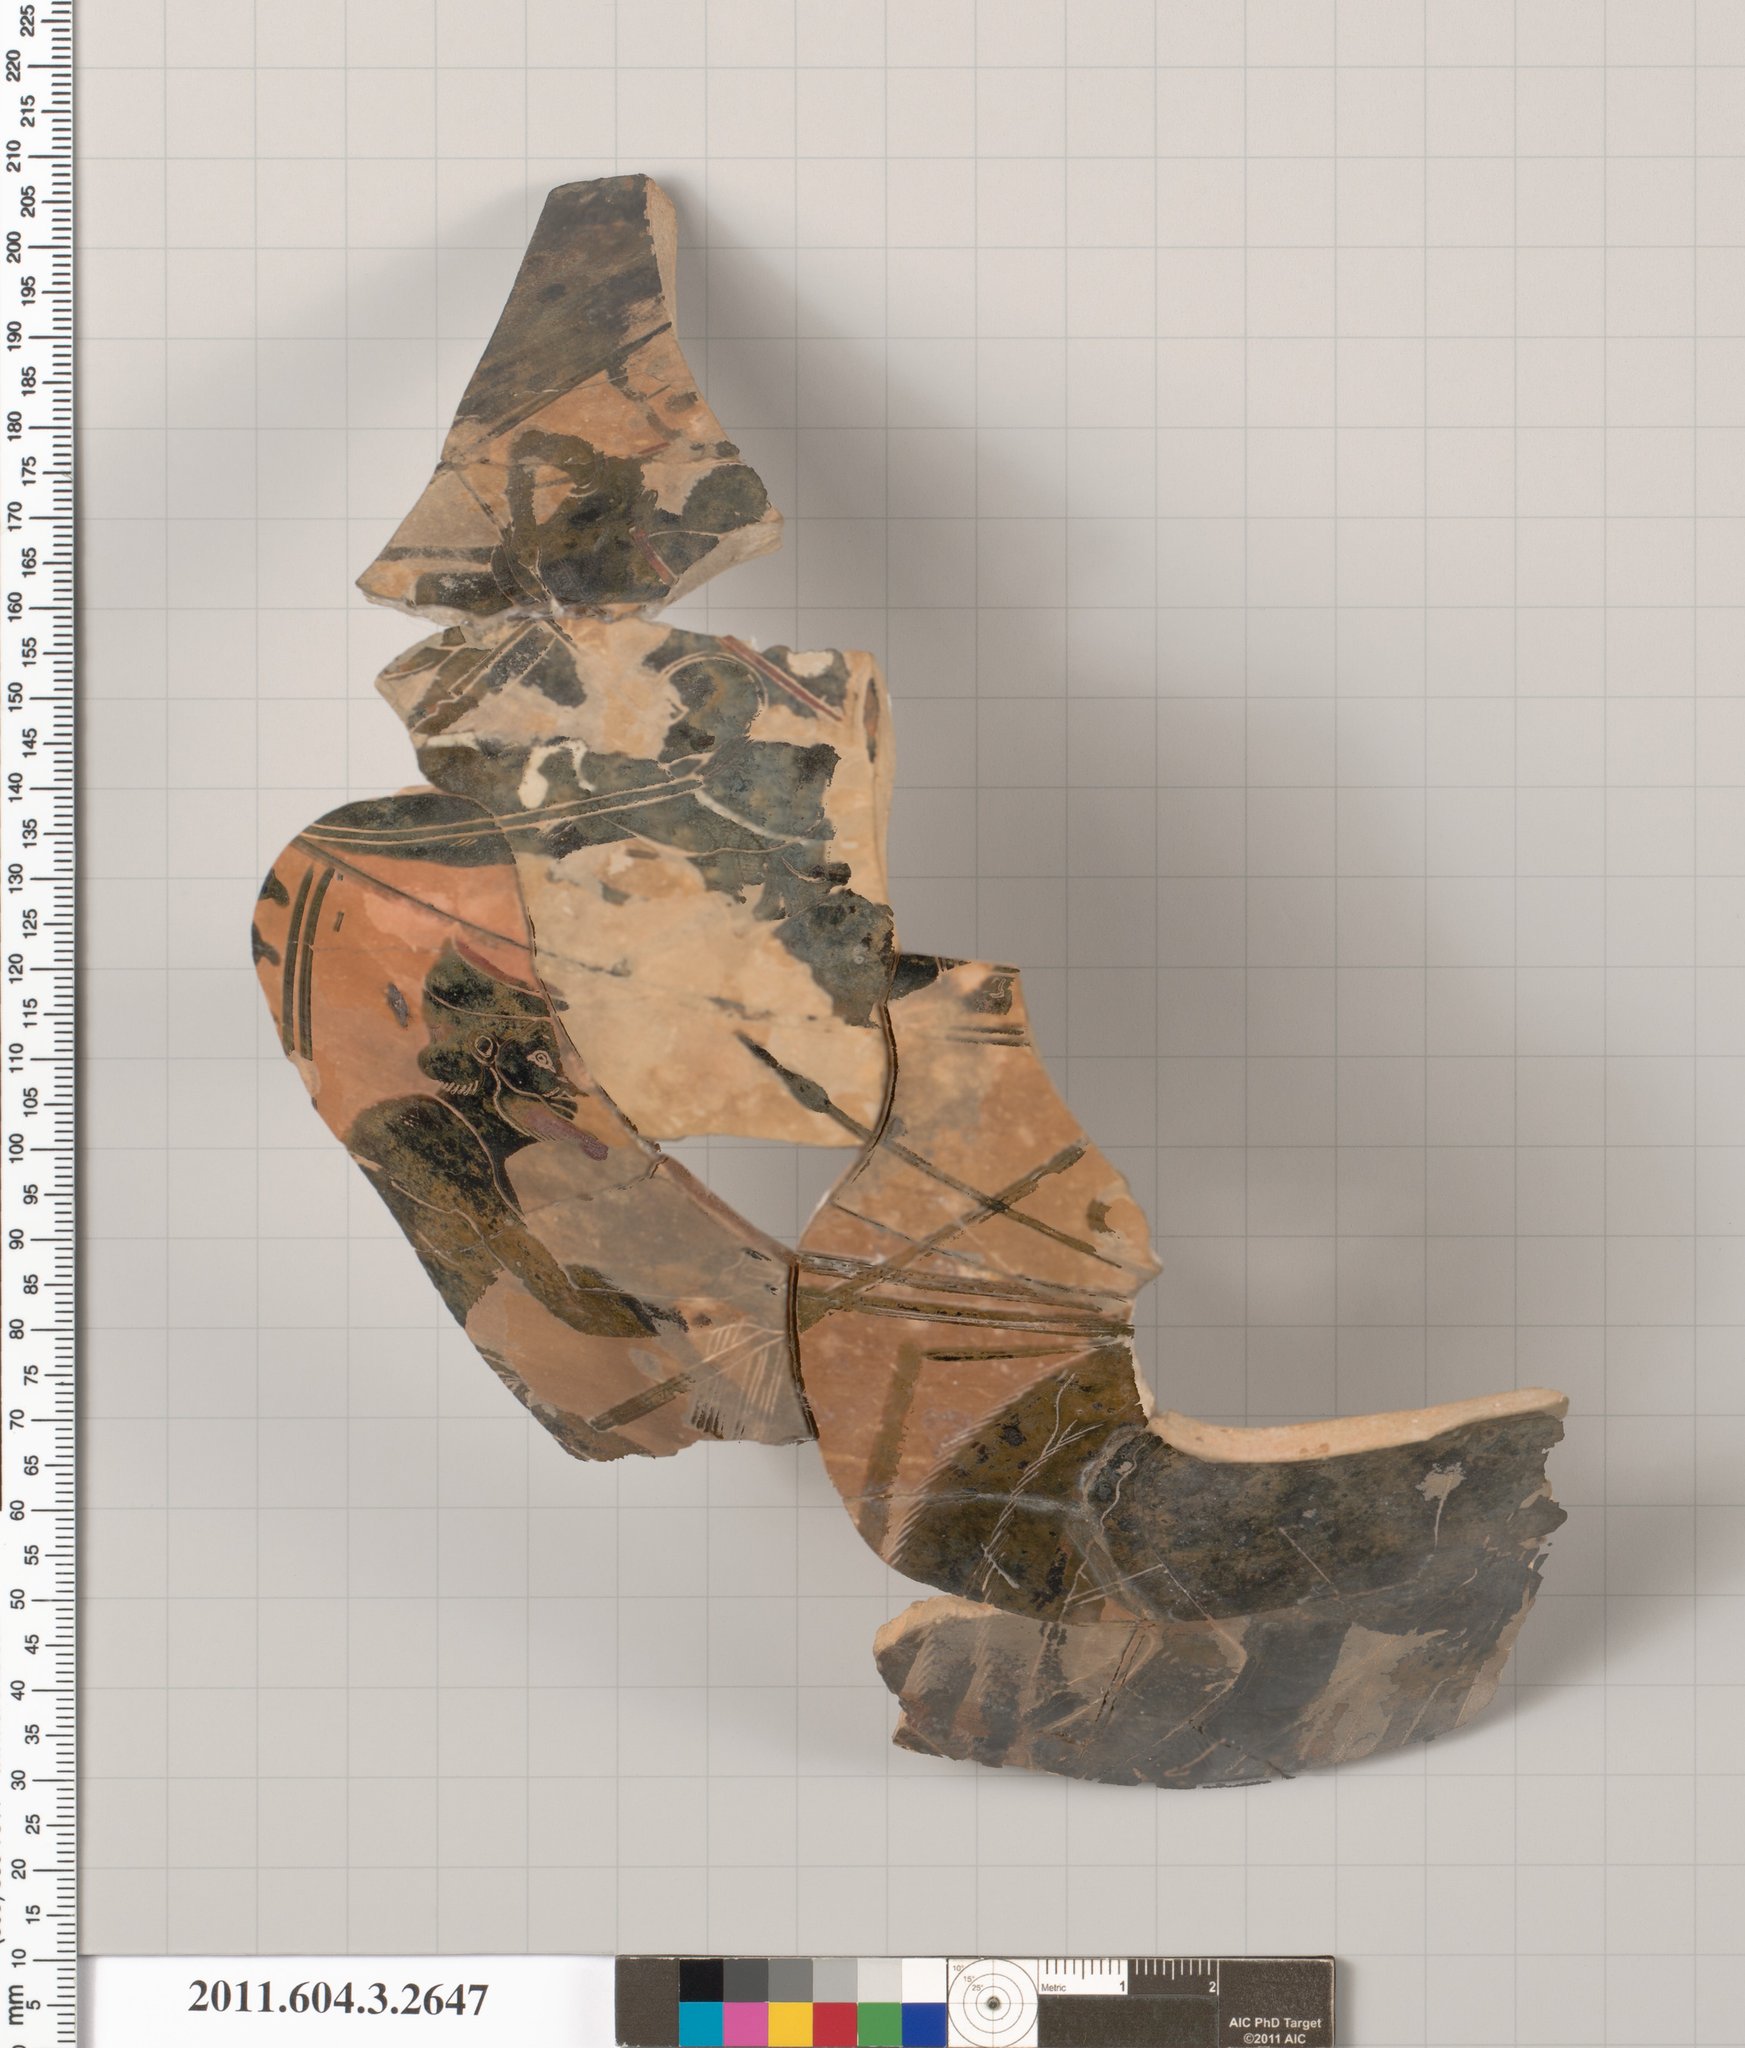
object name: hydria fragment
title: Terracotta fragment of a hydria (water jar)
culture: greek, attic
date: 550-526 BCE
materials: terracotta